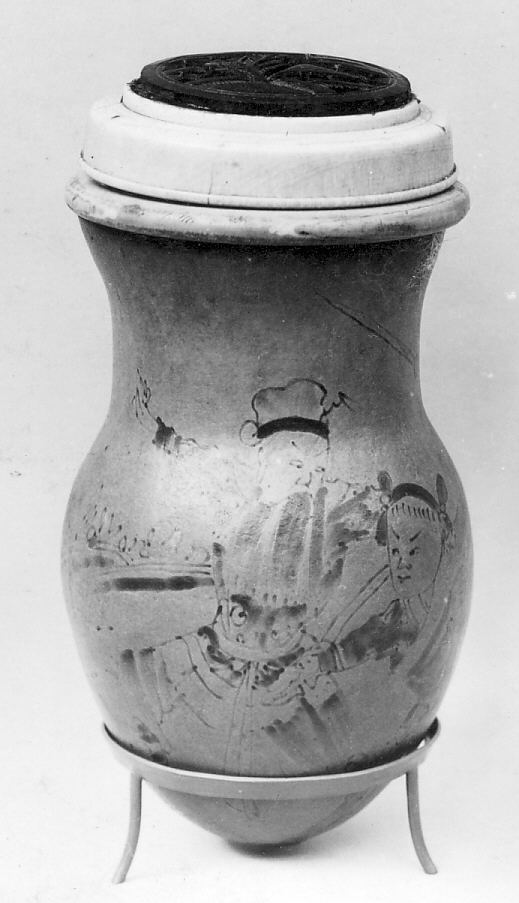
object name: cricket cage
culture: chinese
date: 1701-1900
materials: ivory, wood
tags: men